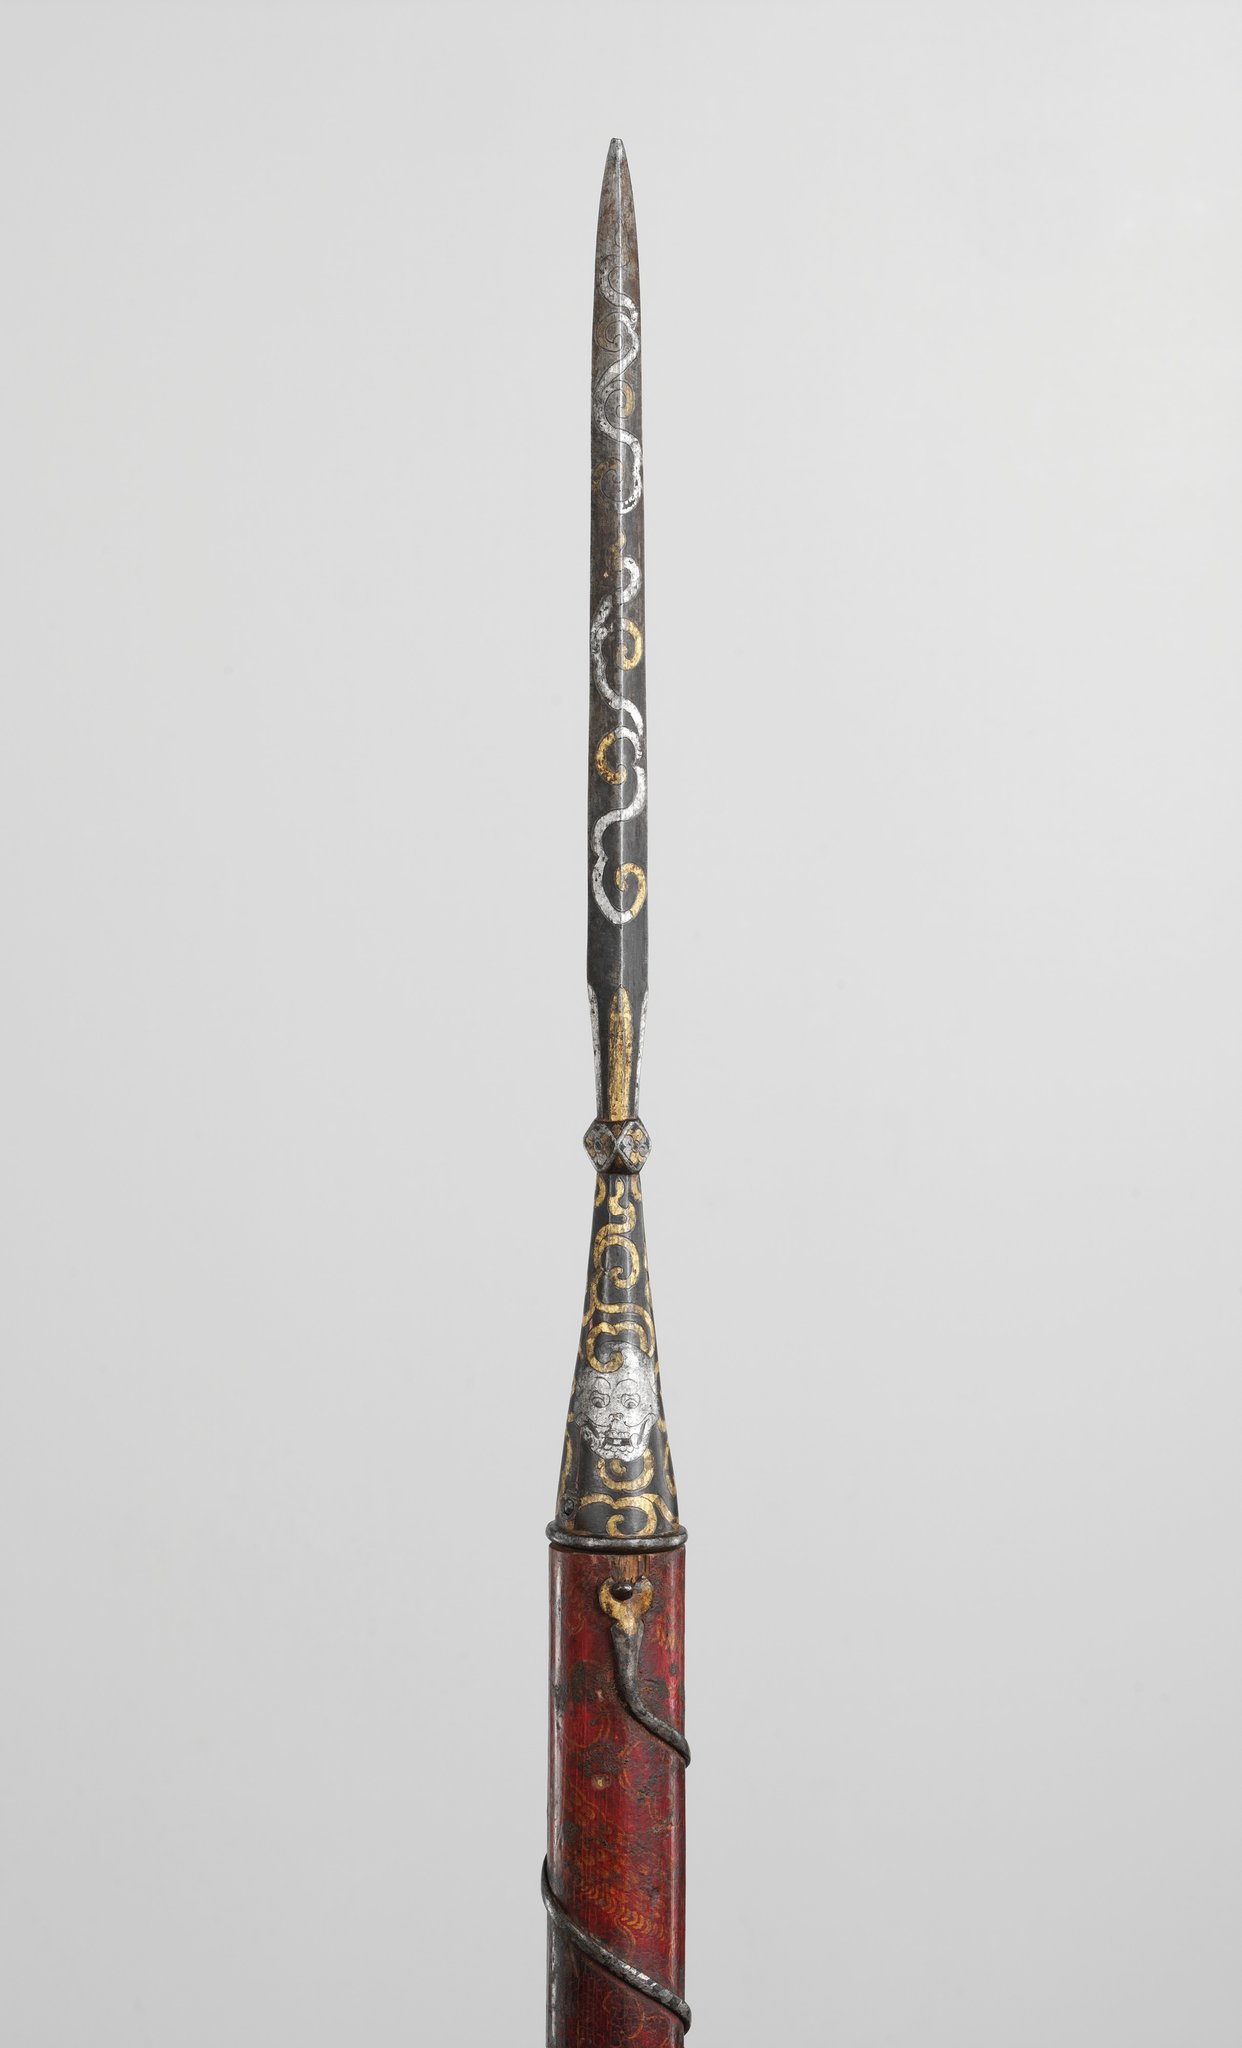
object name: spear mdung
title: Spear Decorated with Tibetan Buddhist Symbols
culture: tibetan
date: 1601-1900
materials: gold, iron, pigment, silver, wood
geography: tibet